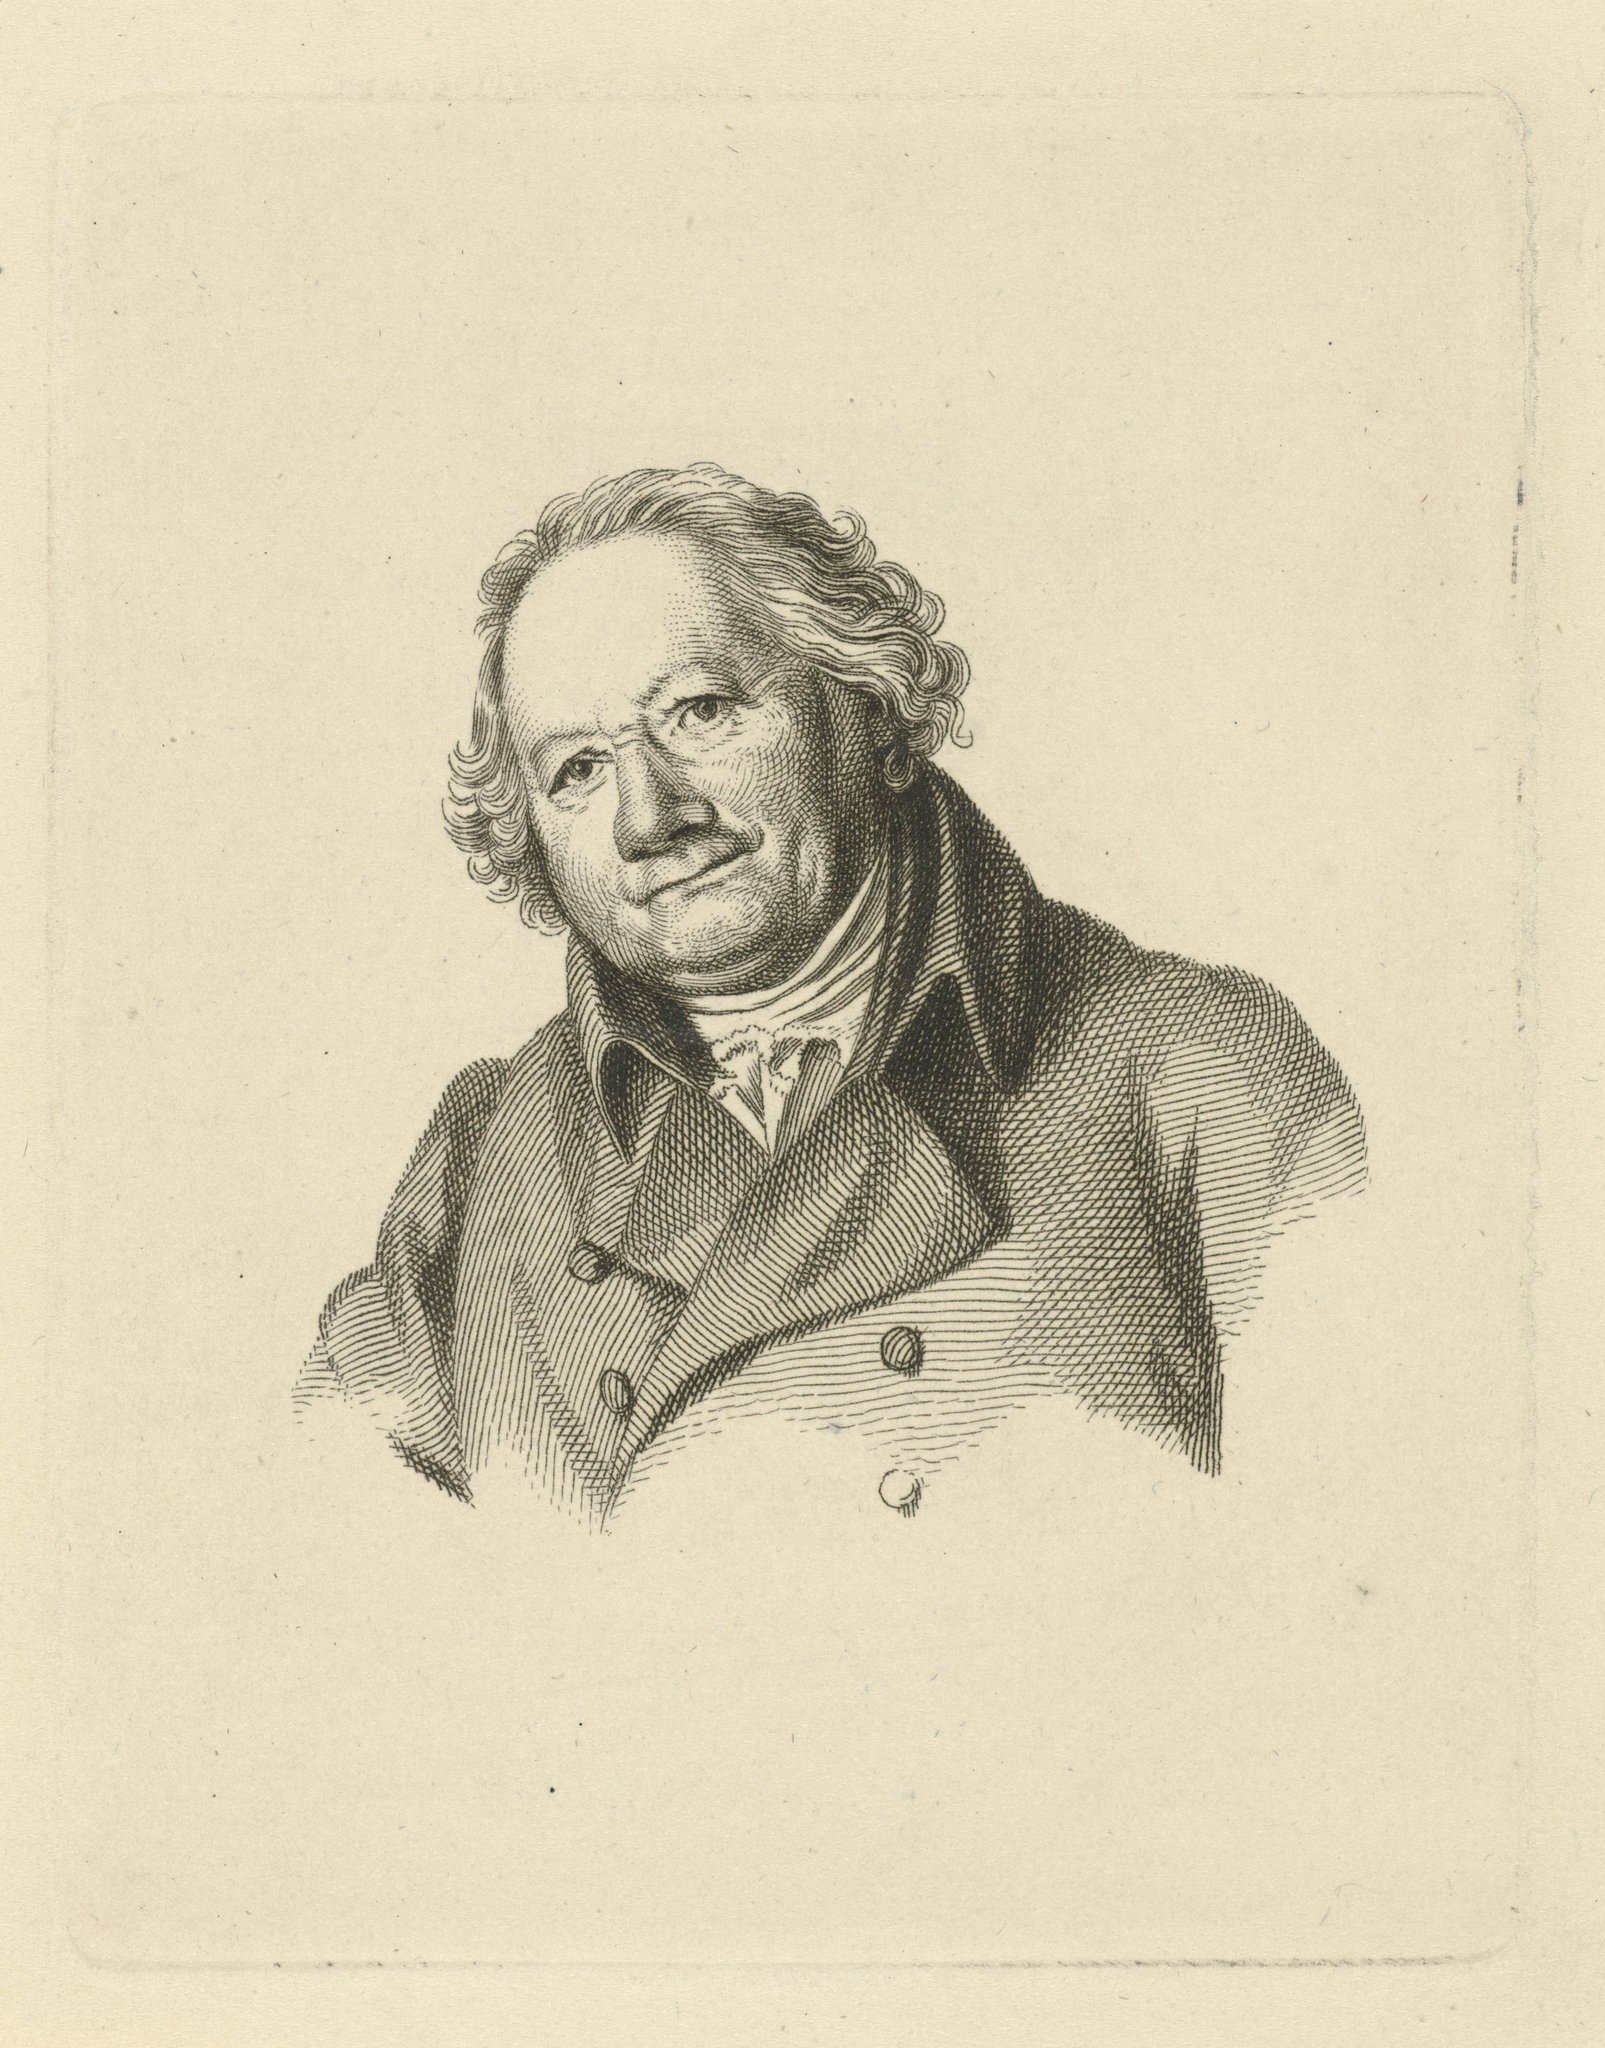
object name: print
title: Portretten van Christiaan Welmeer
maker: jacob ernst marcus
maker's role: draughtsman, print maker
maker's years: 1774-1826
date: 1813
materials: paper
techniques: engraving, etching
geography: amsterdam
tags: sculptor, christiaan welmeer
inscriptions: collector's mark: Lugt 2228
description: Latere staat van de gehele prent gebruikt in: Jacob Ernst Marcus, Etudes gravées. Amsterdam: S. de Grebber, 1826.